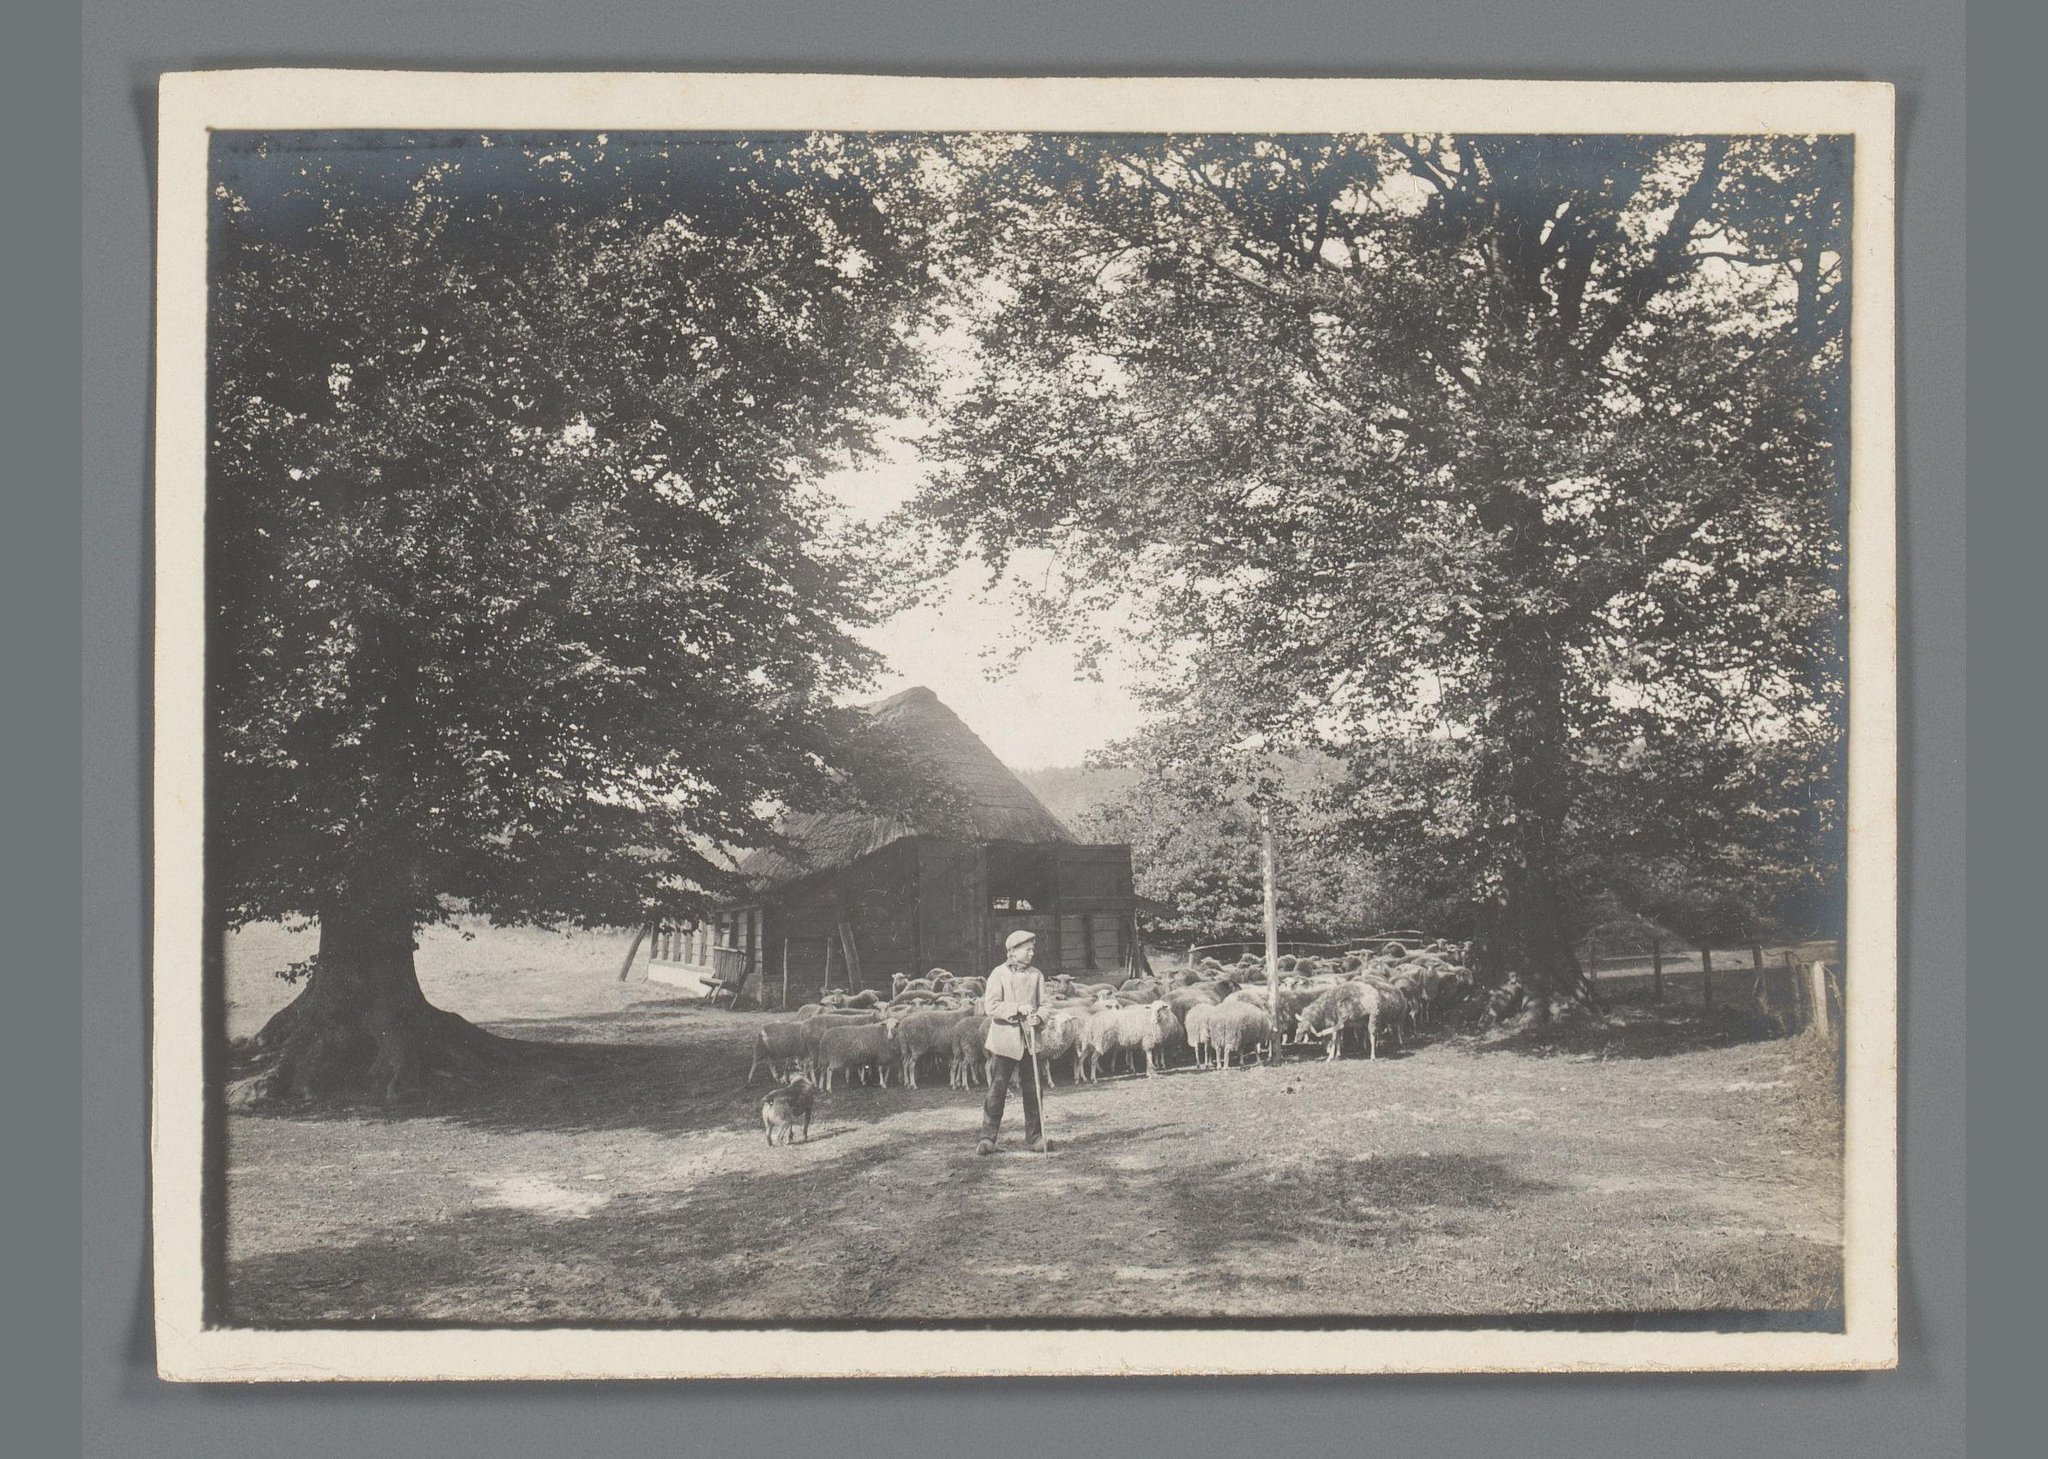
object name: photograph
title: Jongen met schapen bij schuur in Limburg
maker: willem de jong (fotograaf)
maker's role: arts, fotograaf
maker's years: 1864-1918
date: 1895-1918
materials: paper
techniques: gelatin silver print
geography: limburg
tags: sheep, shearing (sheep)